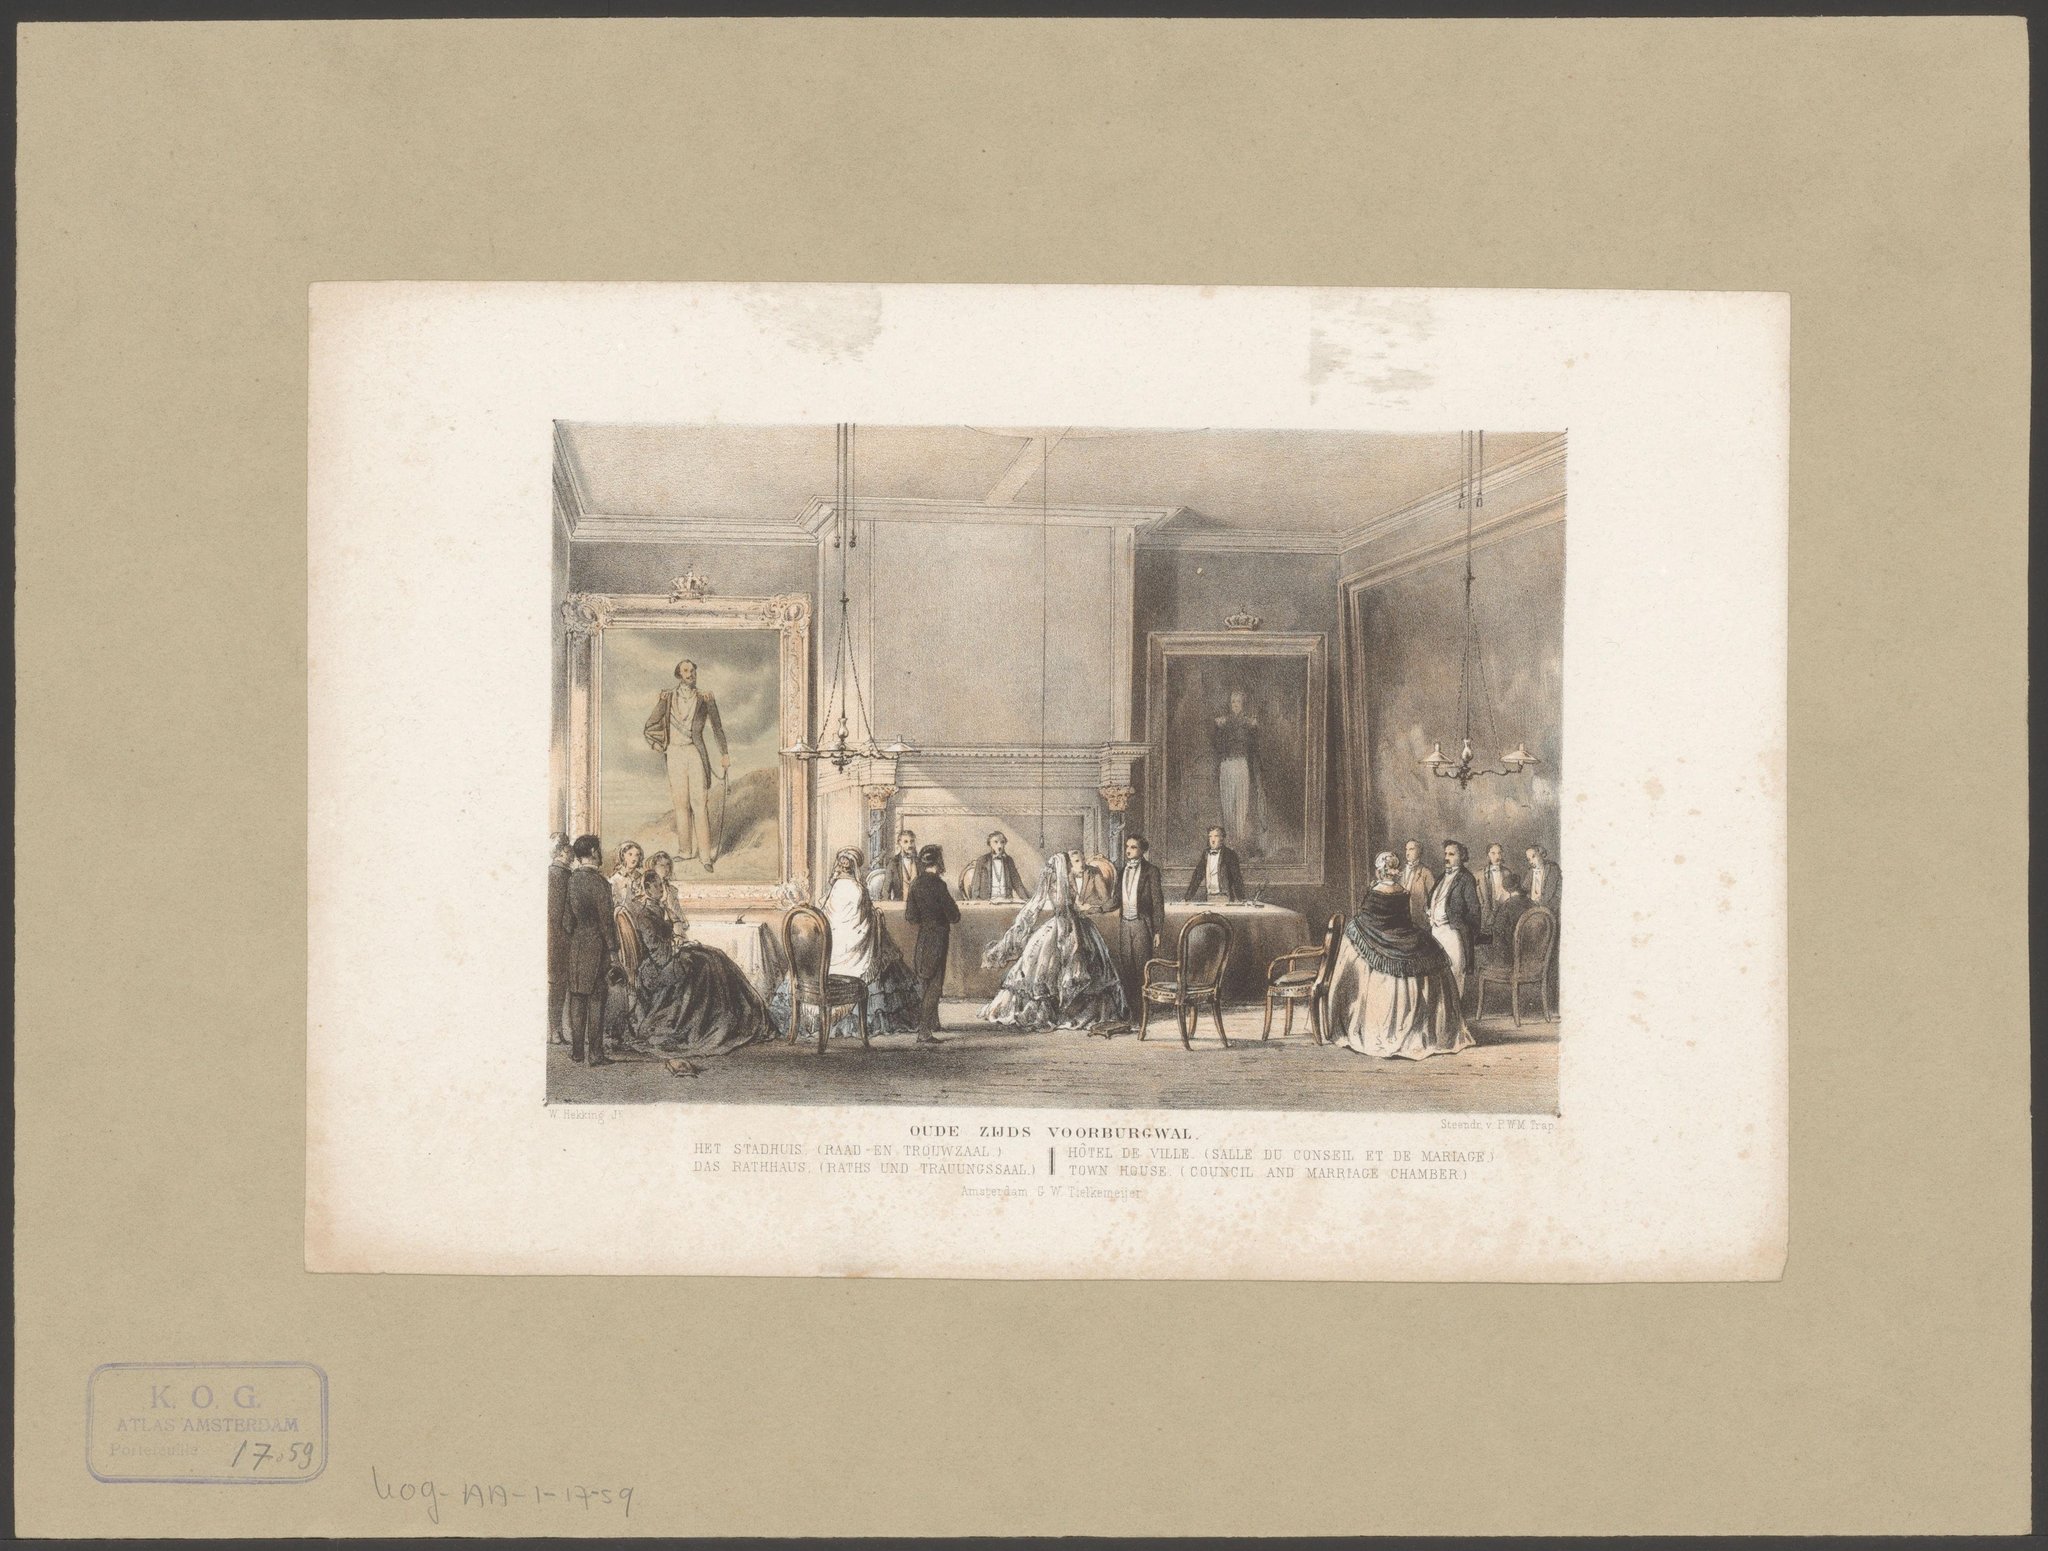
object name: print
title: Gezicht op de Raad- en Trouwzaal van het stadhuis op het Prinsenhof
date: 1835-1904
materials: paper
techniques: tone lithography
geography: leiden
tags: bride and groom in wedding-dress, townhall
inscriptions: collector's mark: ‘17.59’ Lugt 1641b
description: Onderwerpsrubriek binnen de Atlas Amsterdam: Nieuwe Stadhuis, van binnen: Vaartuigen en Gebouwen ten dienste der Stedelijke Regeering en Administratie; Stadhuis (Prinsenhof).